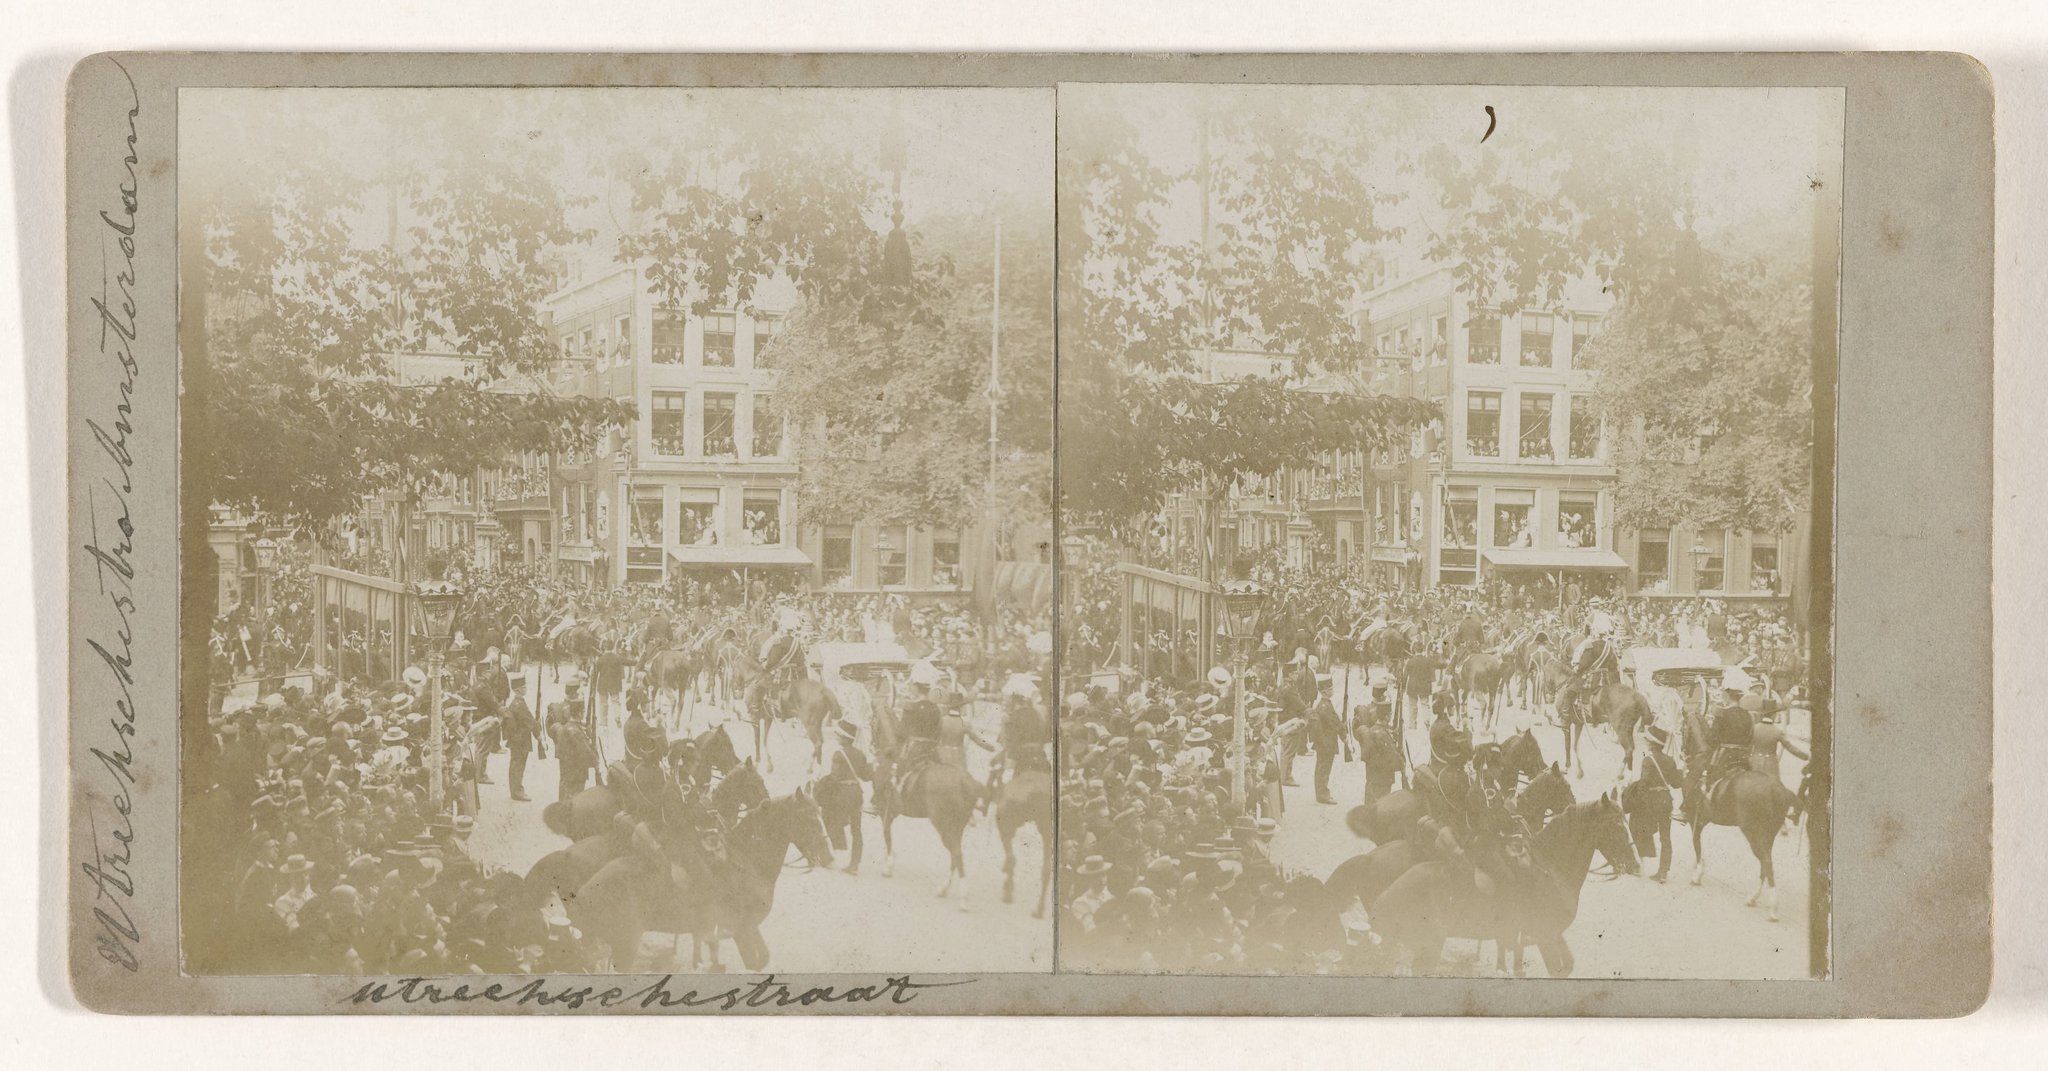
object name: stereograph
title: Optocht tijdens de kroningsfeesten van koningin Wilhelmina in de Utrechtsestraat, Amsterdam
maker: Anonymous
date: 1898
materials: paper, cardboard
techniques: collodion silver print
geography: amsterdam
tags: print maker, wilhelmina of the netherlands, the hague, emma (queen consort of the netherlands), public festivities on the occasion of royal events, coronation of a ruler, ceremonial procession, parade, pageant ~ installation of a ruler - bb - female ruler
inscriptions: inscription: ‘Versierde Utrechtsche/ straat tijdens de/ kroning feesten van/ koningin Wilhelmina/ de twee witte gedaante/ in dat wit rijtuig is/ koningin Wilhelmina/ en haar moeder’